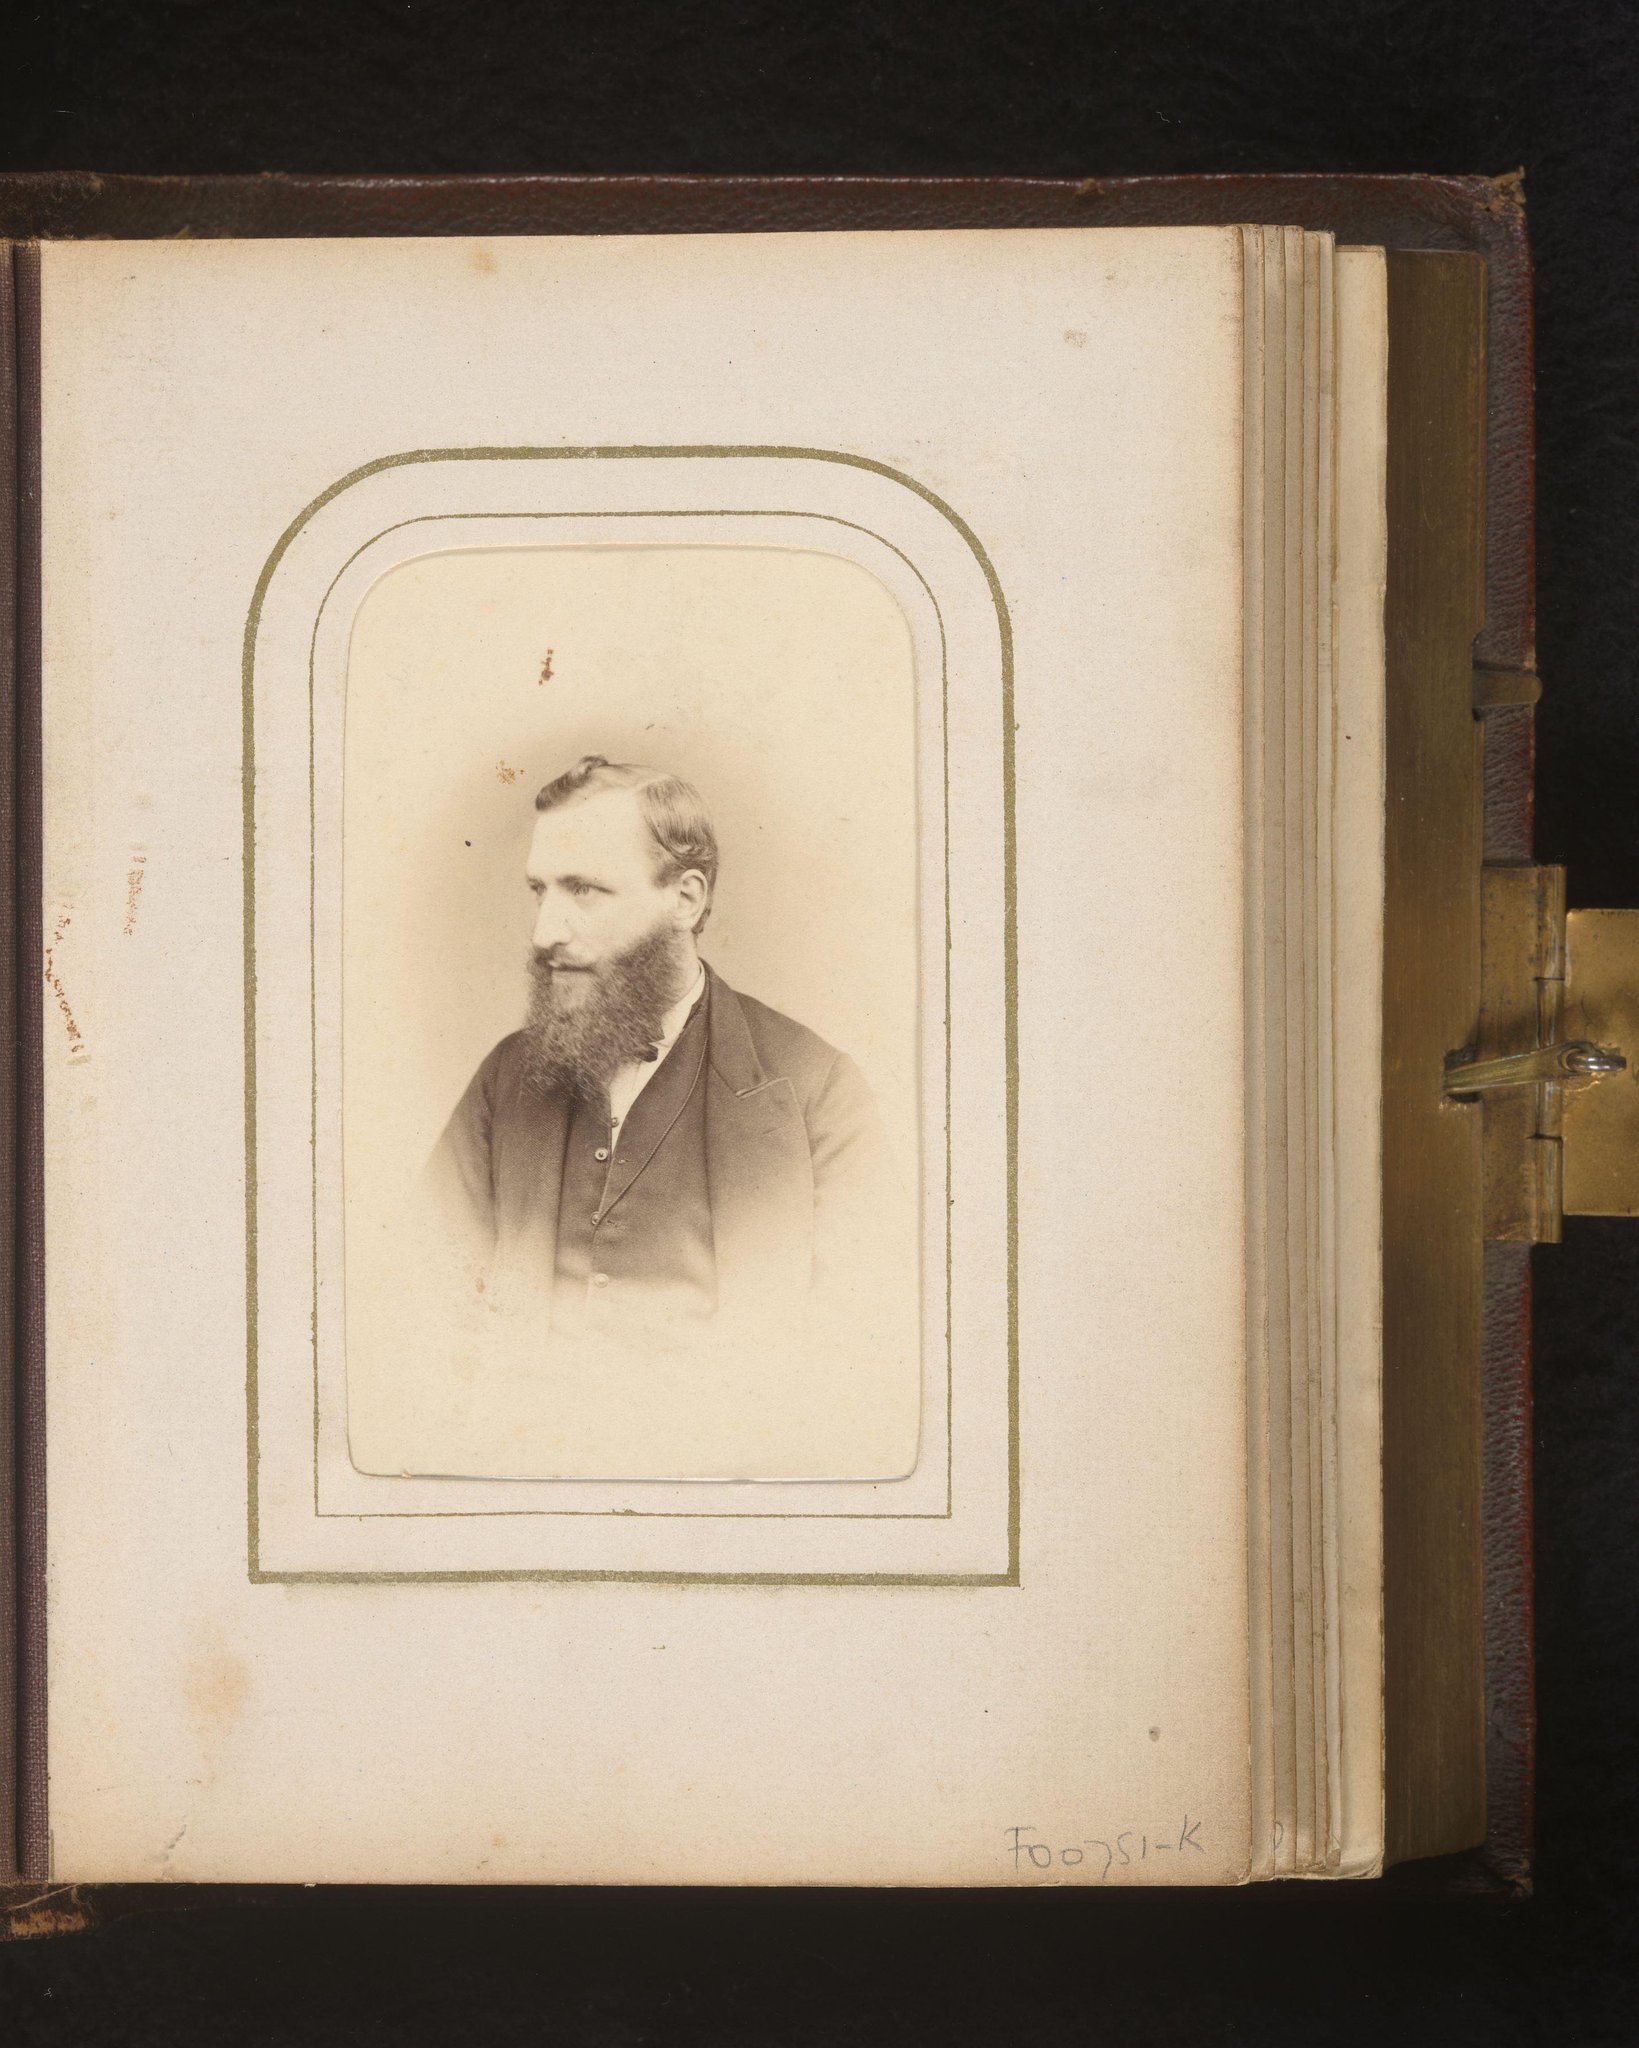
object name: album leaf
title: Portret van een man met baard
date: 1860-1900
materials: cardboard, photographic support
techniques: albumen print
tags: adult man, historical persons, beard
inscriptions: inscription: ‘Mr & Mrs Bustin/ Photographers/ Hereford/ and/ Ross/ (...)’